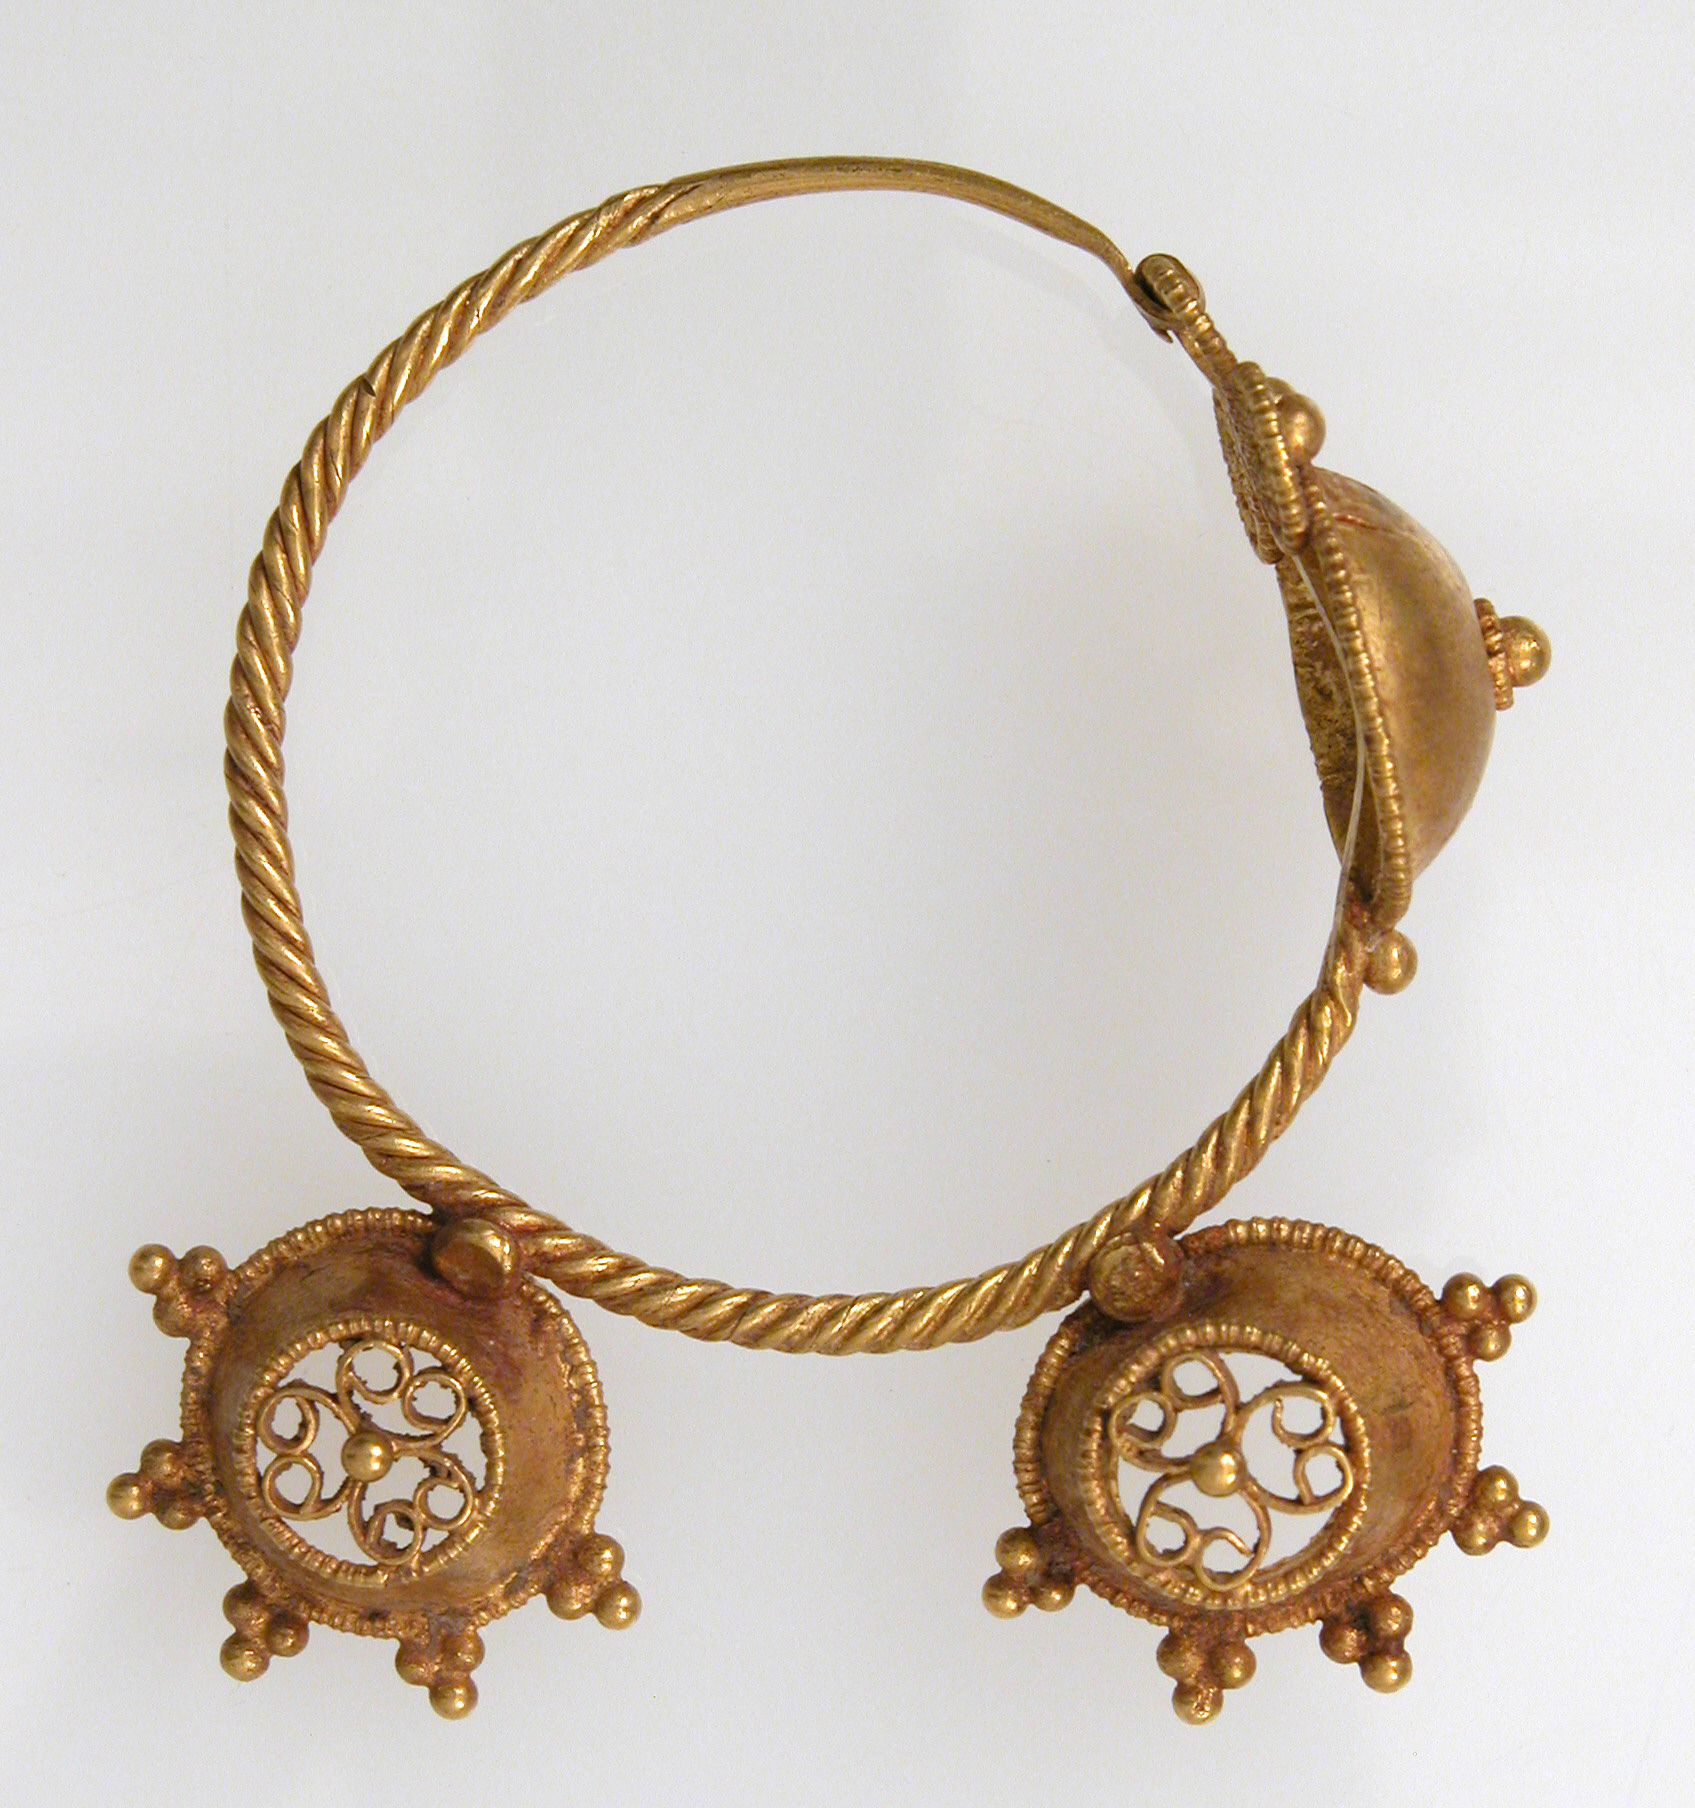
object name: earring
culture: langobardic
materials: gold